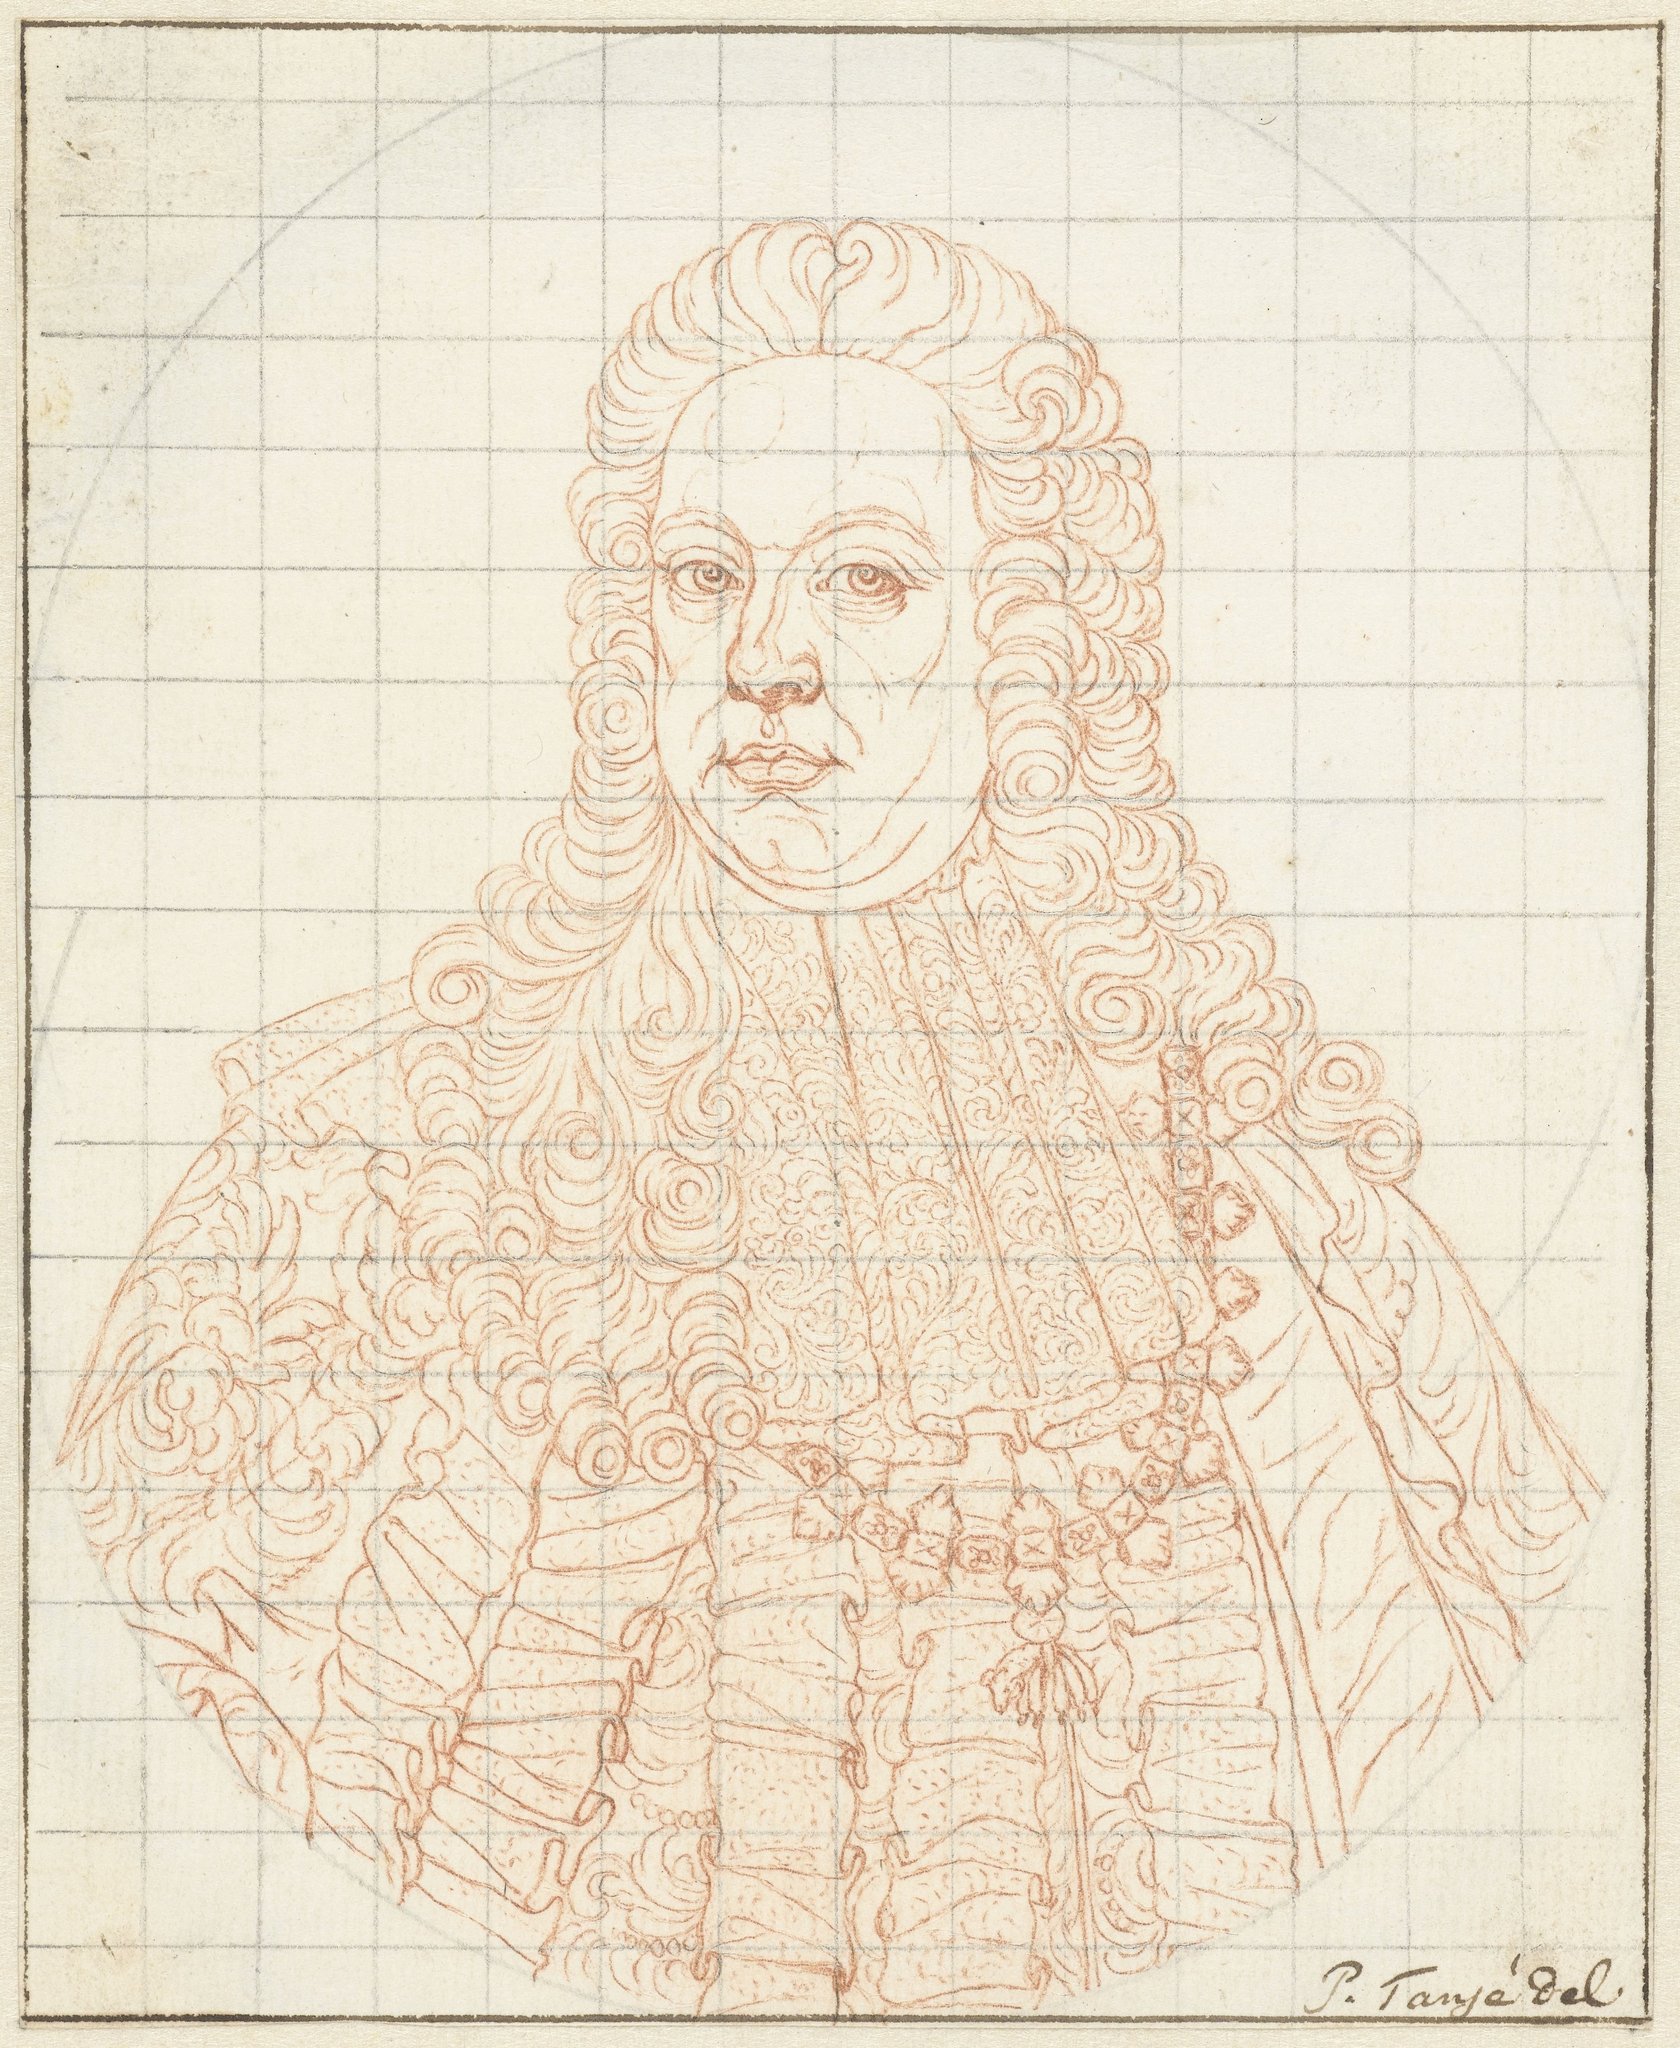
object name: drawing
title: Portret van Frans I Stephanus, Duits keizer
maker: pieter tanjé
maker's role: draughtsman, print maker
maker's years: 1706-1761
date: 1741-1761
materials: ink, paper, pencil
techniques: pen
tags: frans i stefan (duits keizer), historical persons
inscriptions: inscription: ‘P. Tanjé Del’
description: Portret van Frans I Stephanus (1708-1765), Duits keizer. Ontwerp voor een prent.